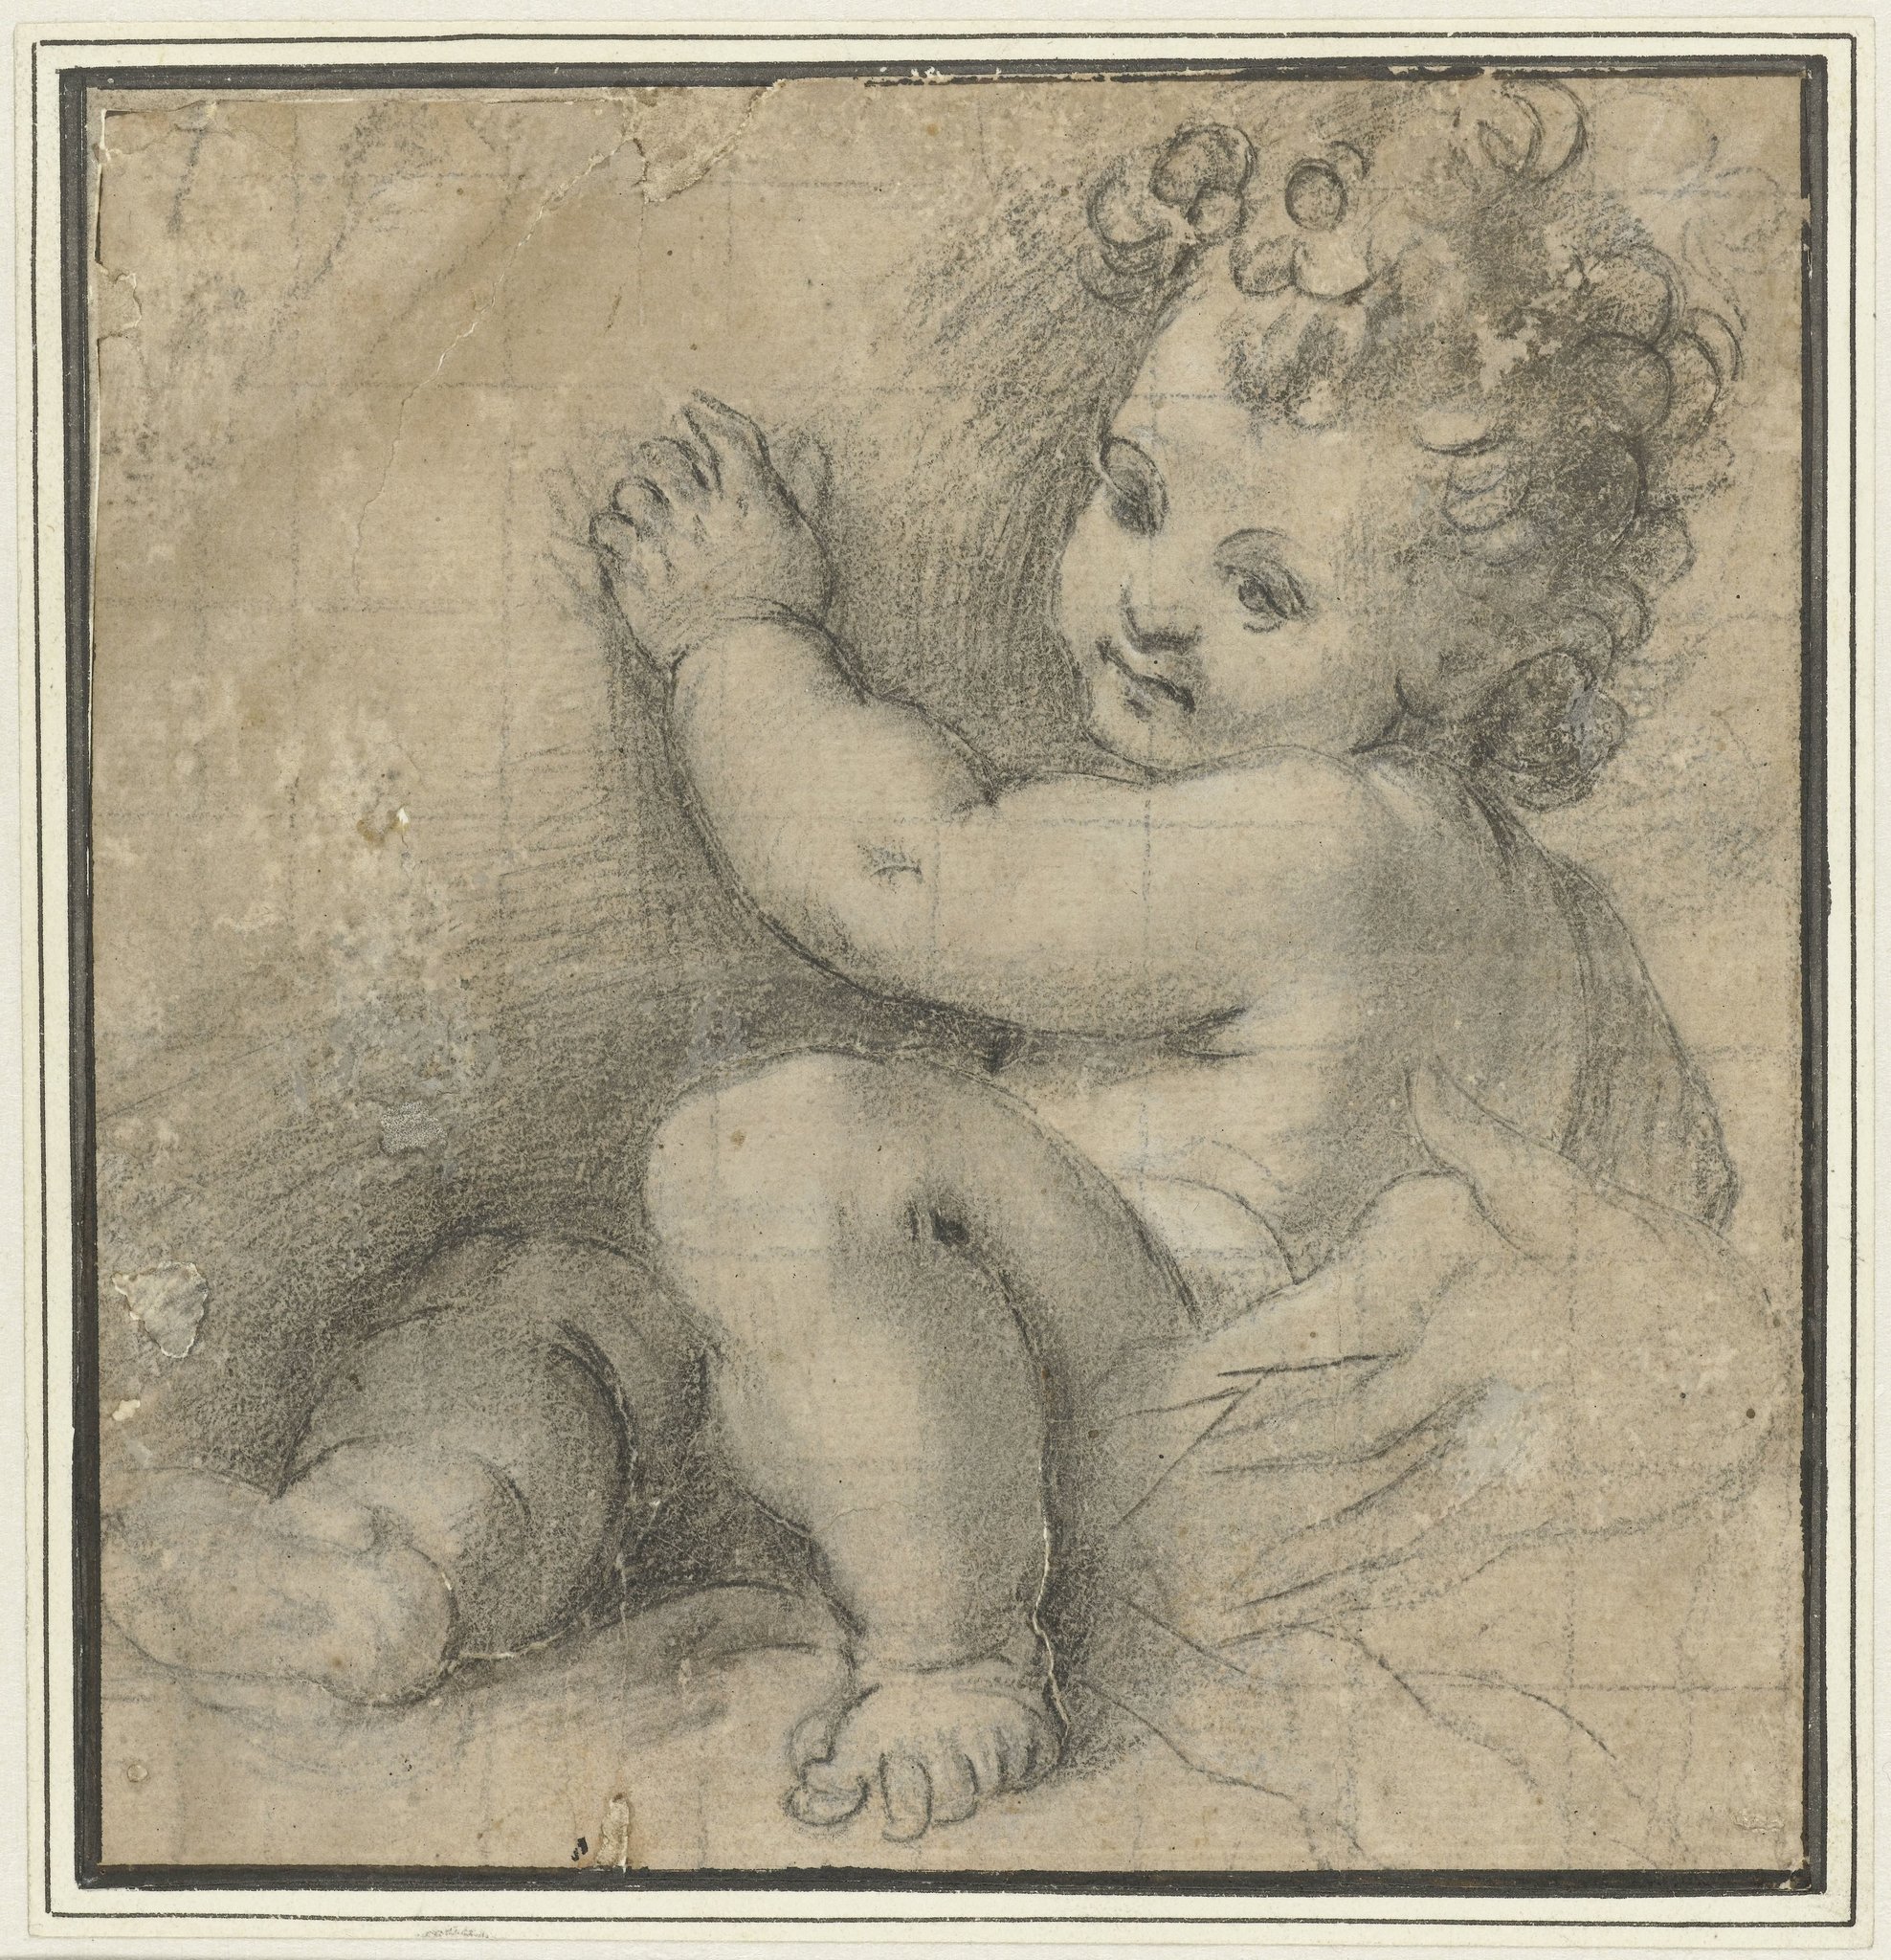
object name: drawing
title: Christuskind met de hand van Maria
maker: federico barocci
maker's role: draughtsman, painter, print maker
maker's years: 1528-1612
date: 1545-1577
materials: chalk, paper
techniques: drawing